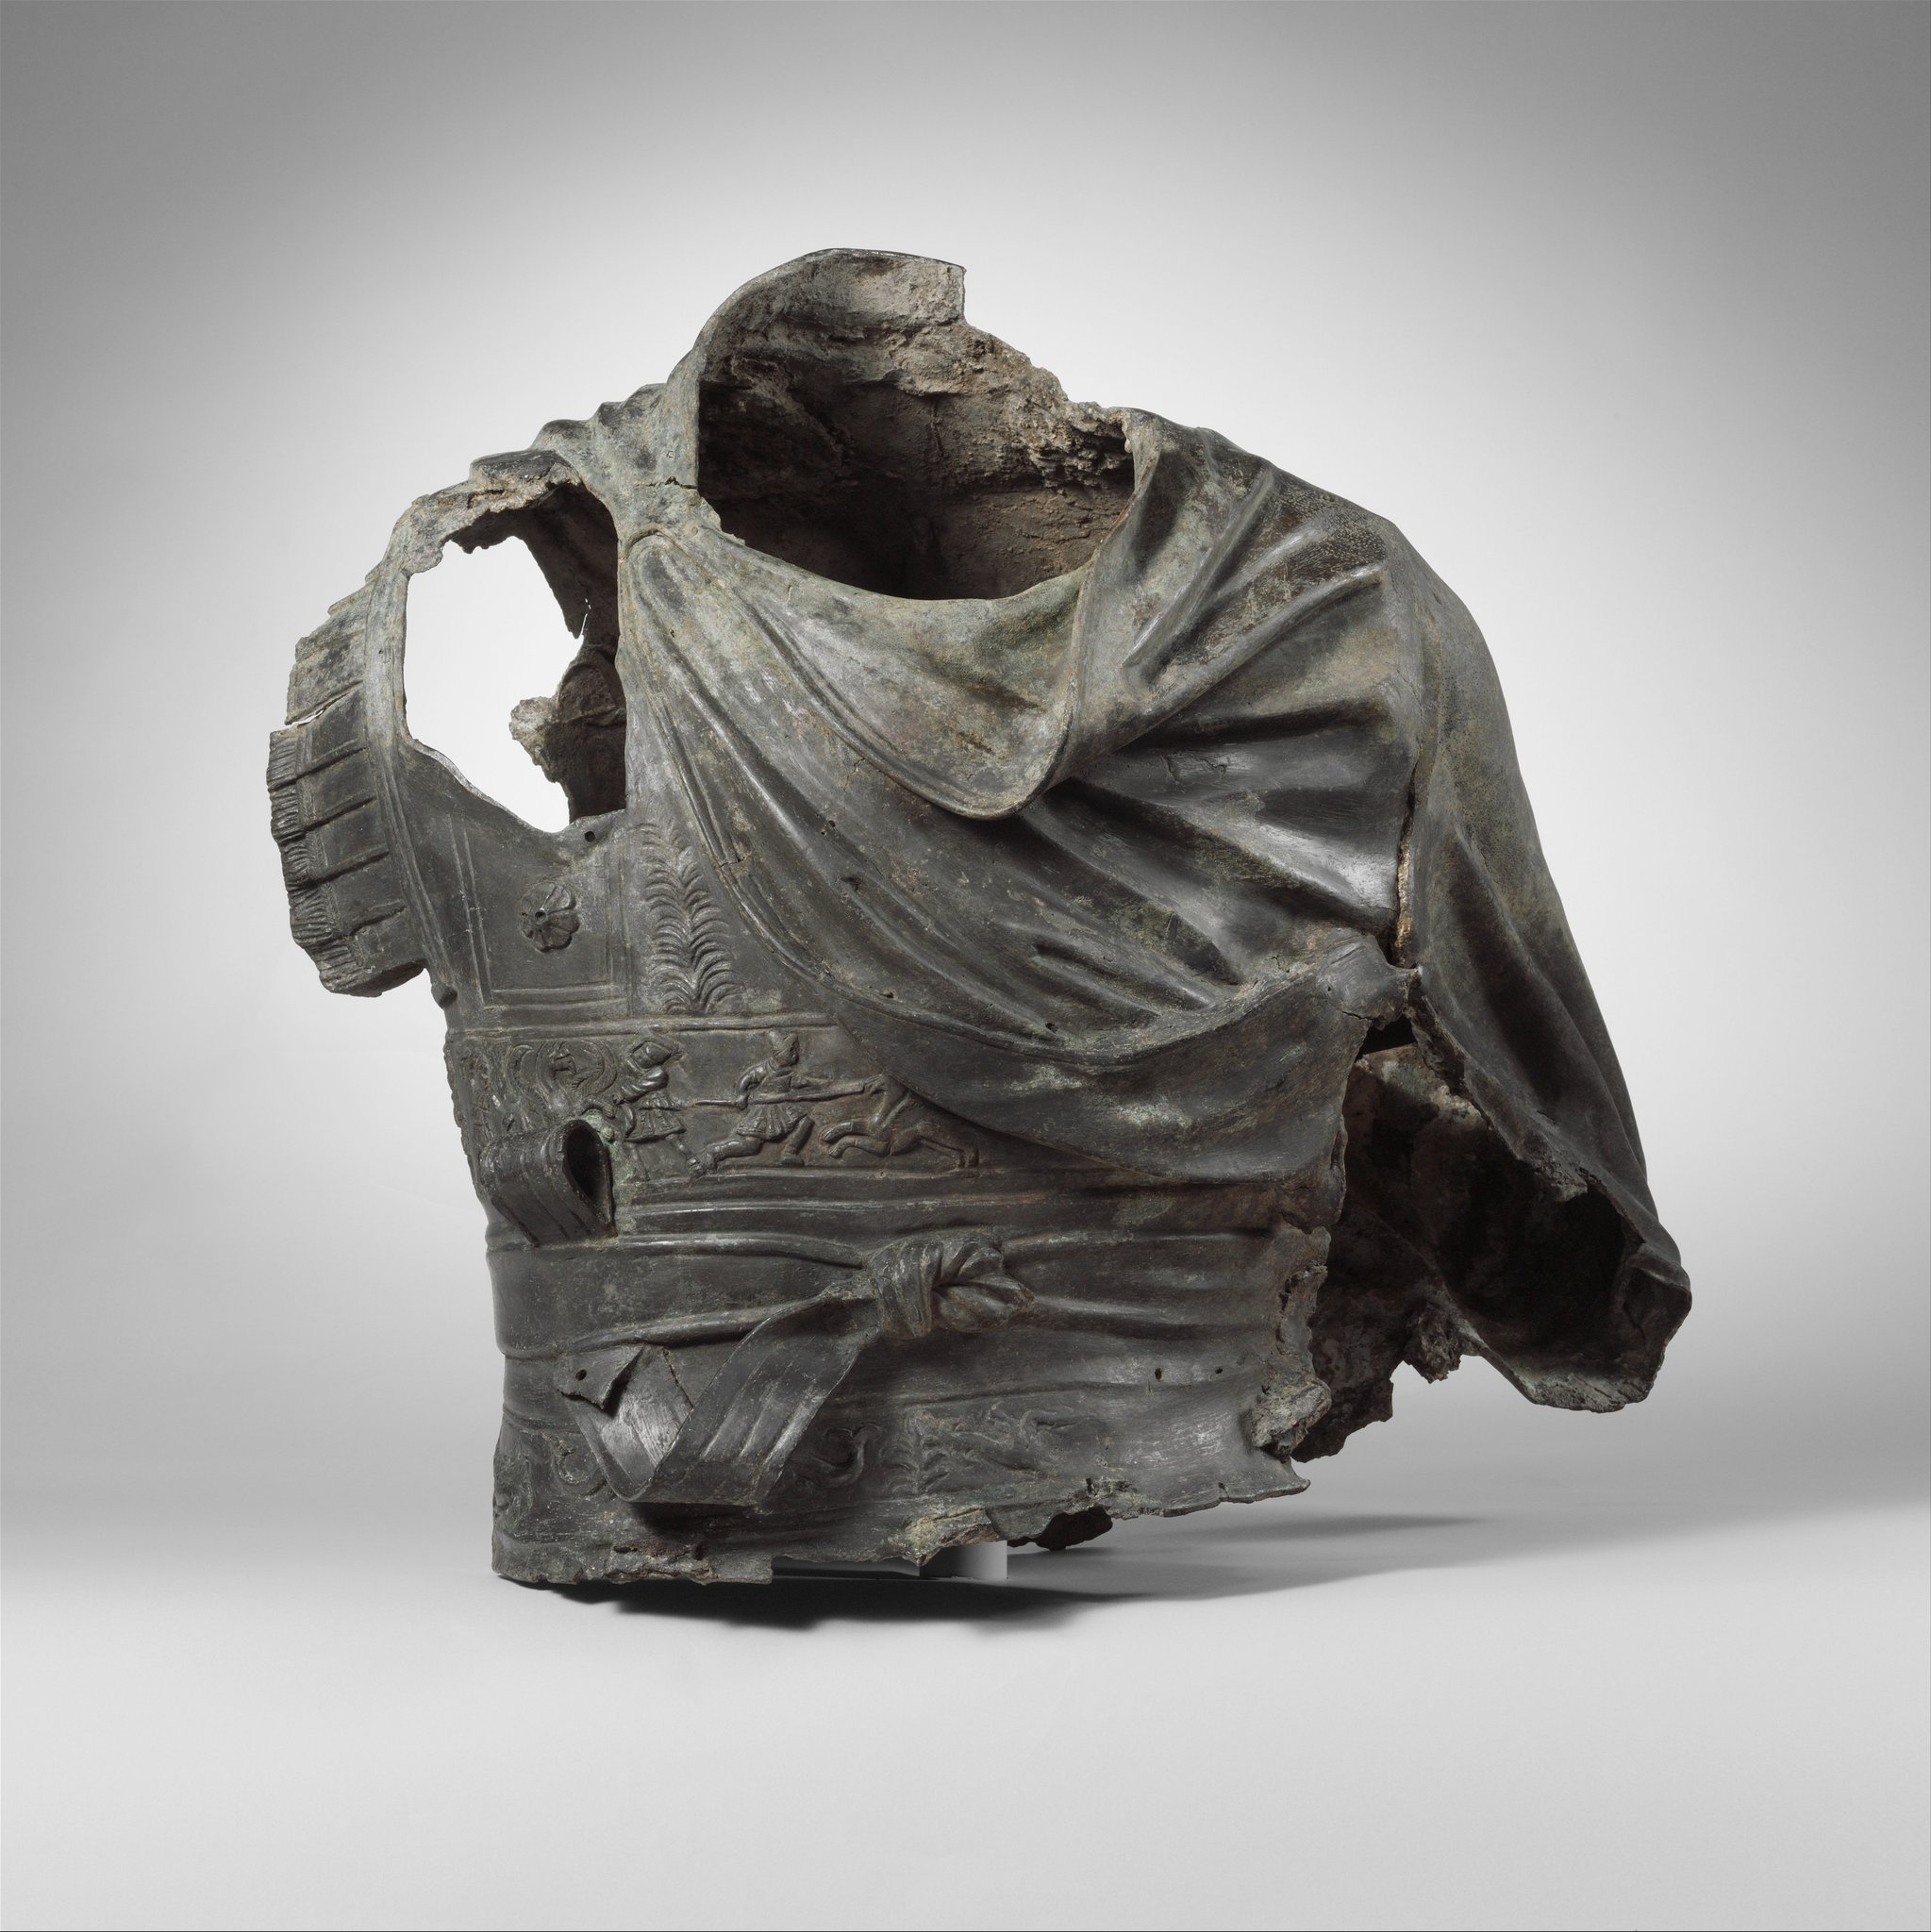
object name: torso from an equestrian statue wearing a cuirass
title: Bronze torso from an equestrian statue wearing a cuirass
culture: greek or roman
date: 200 BCE-200 CE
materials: bronze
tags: armor